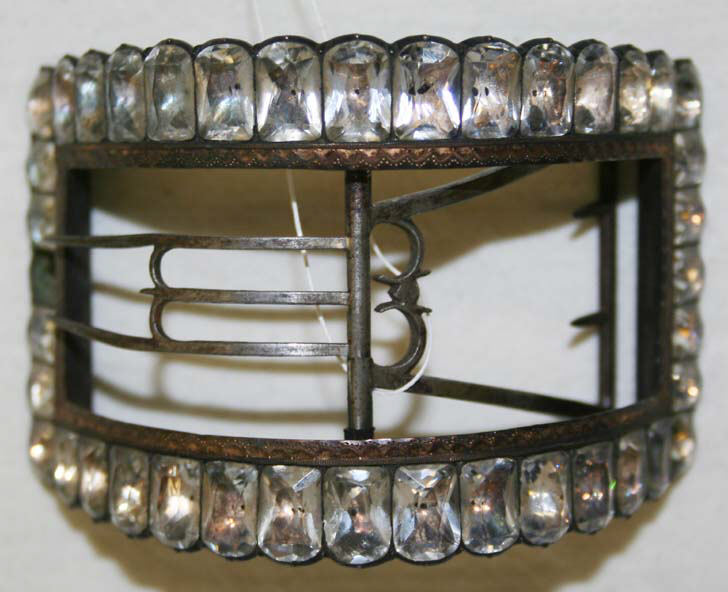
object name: shoe buckle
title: Shoe buckles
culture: british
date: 1767-1800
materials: metal, paste